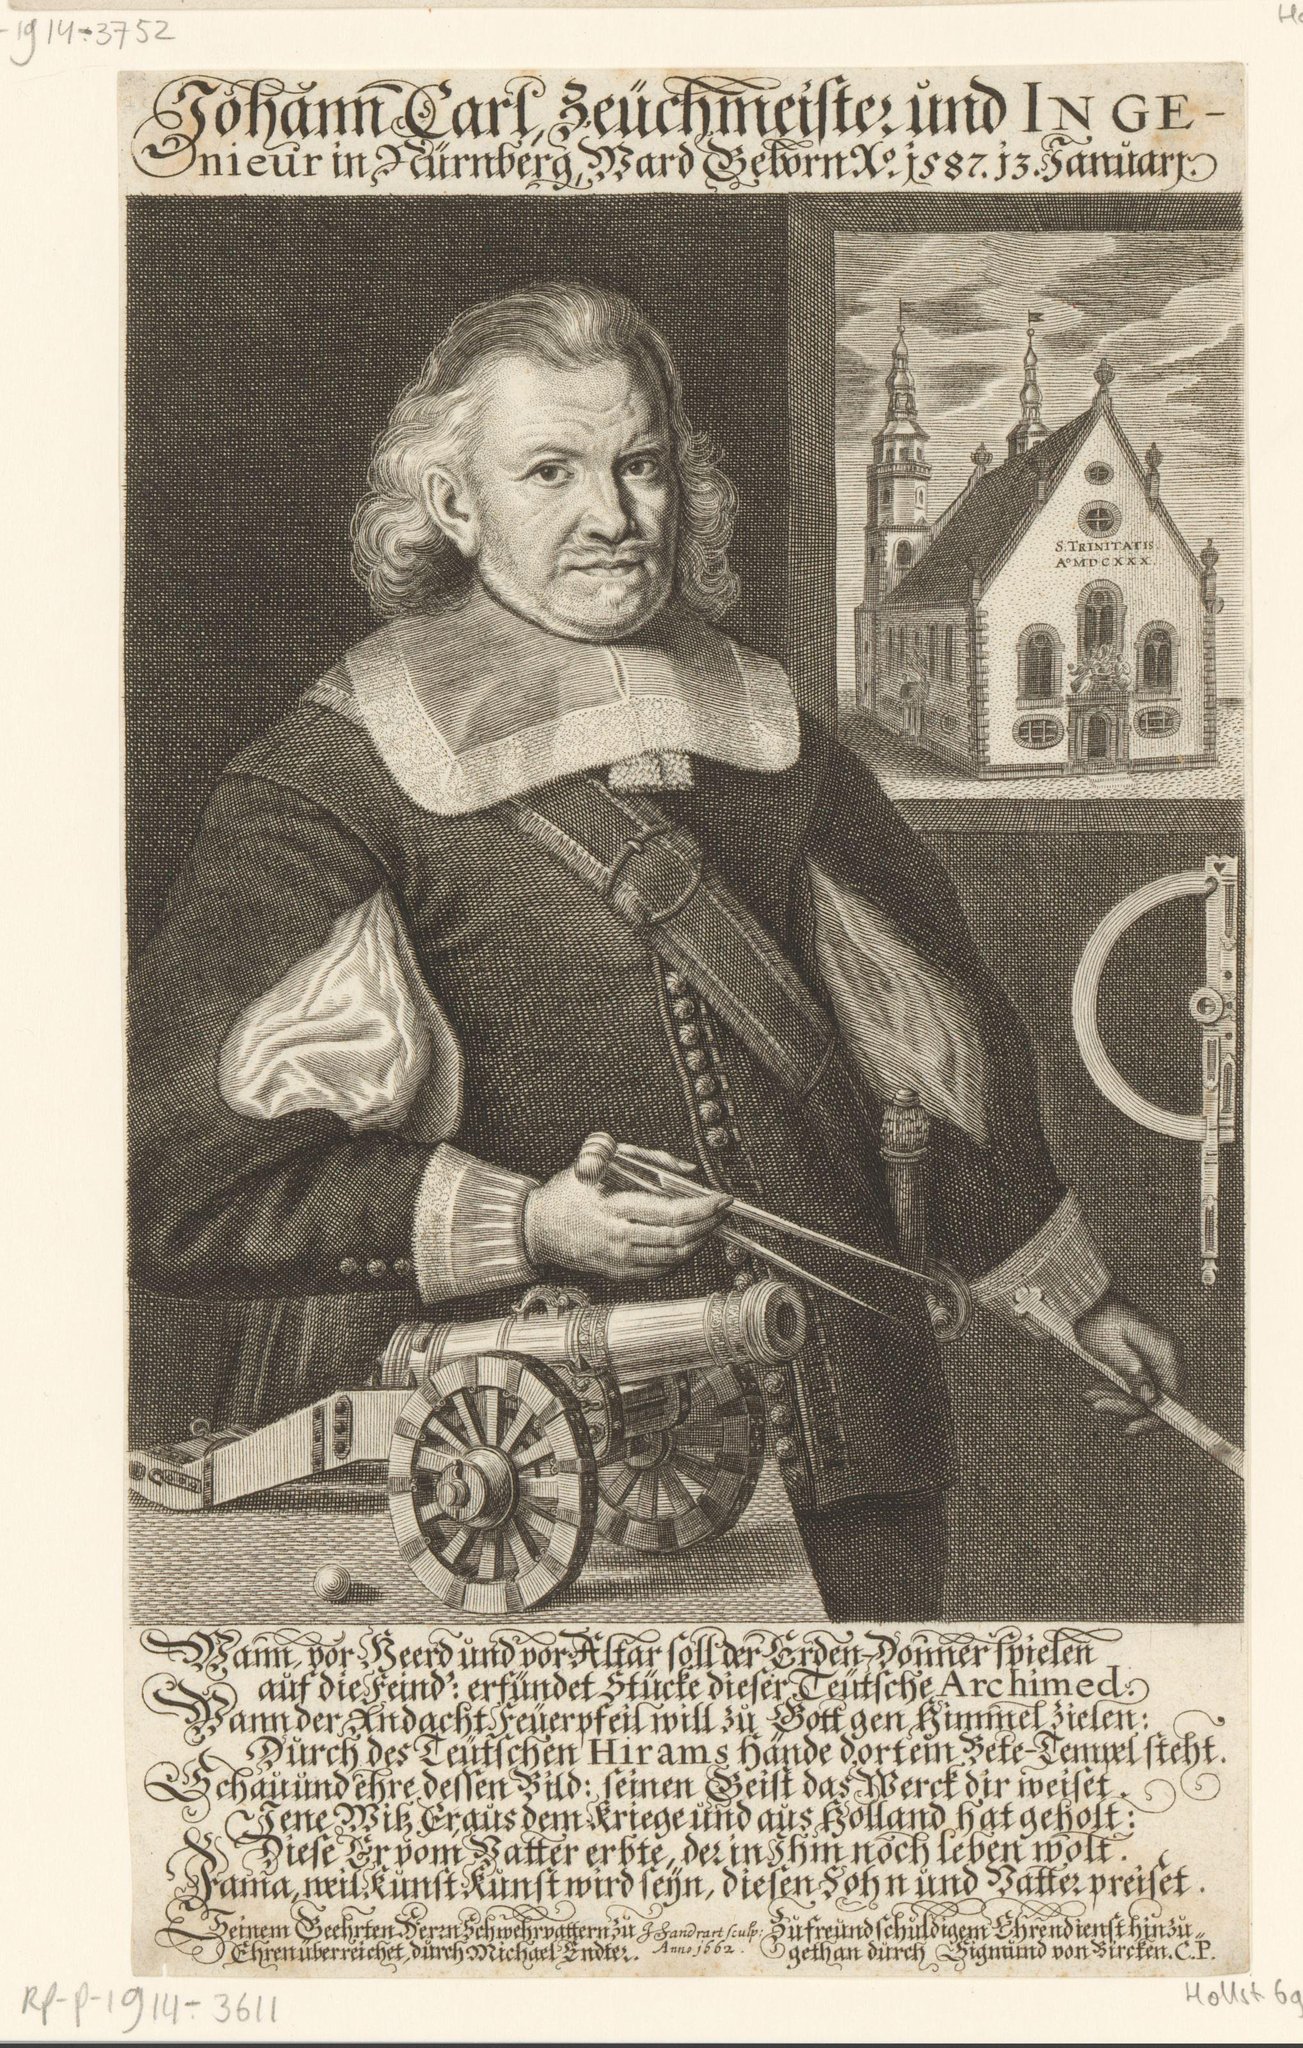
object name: print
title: Portret van Johann Carl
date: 1662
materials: paper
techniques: engraving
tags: historical persons, portrait, self-portrait of architect, firearms: cannon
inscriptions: collector's mark: Lugt 2228